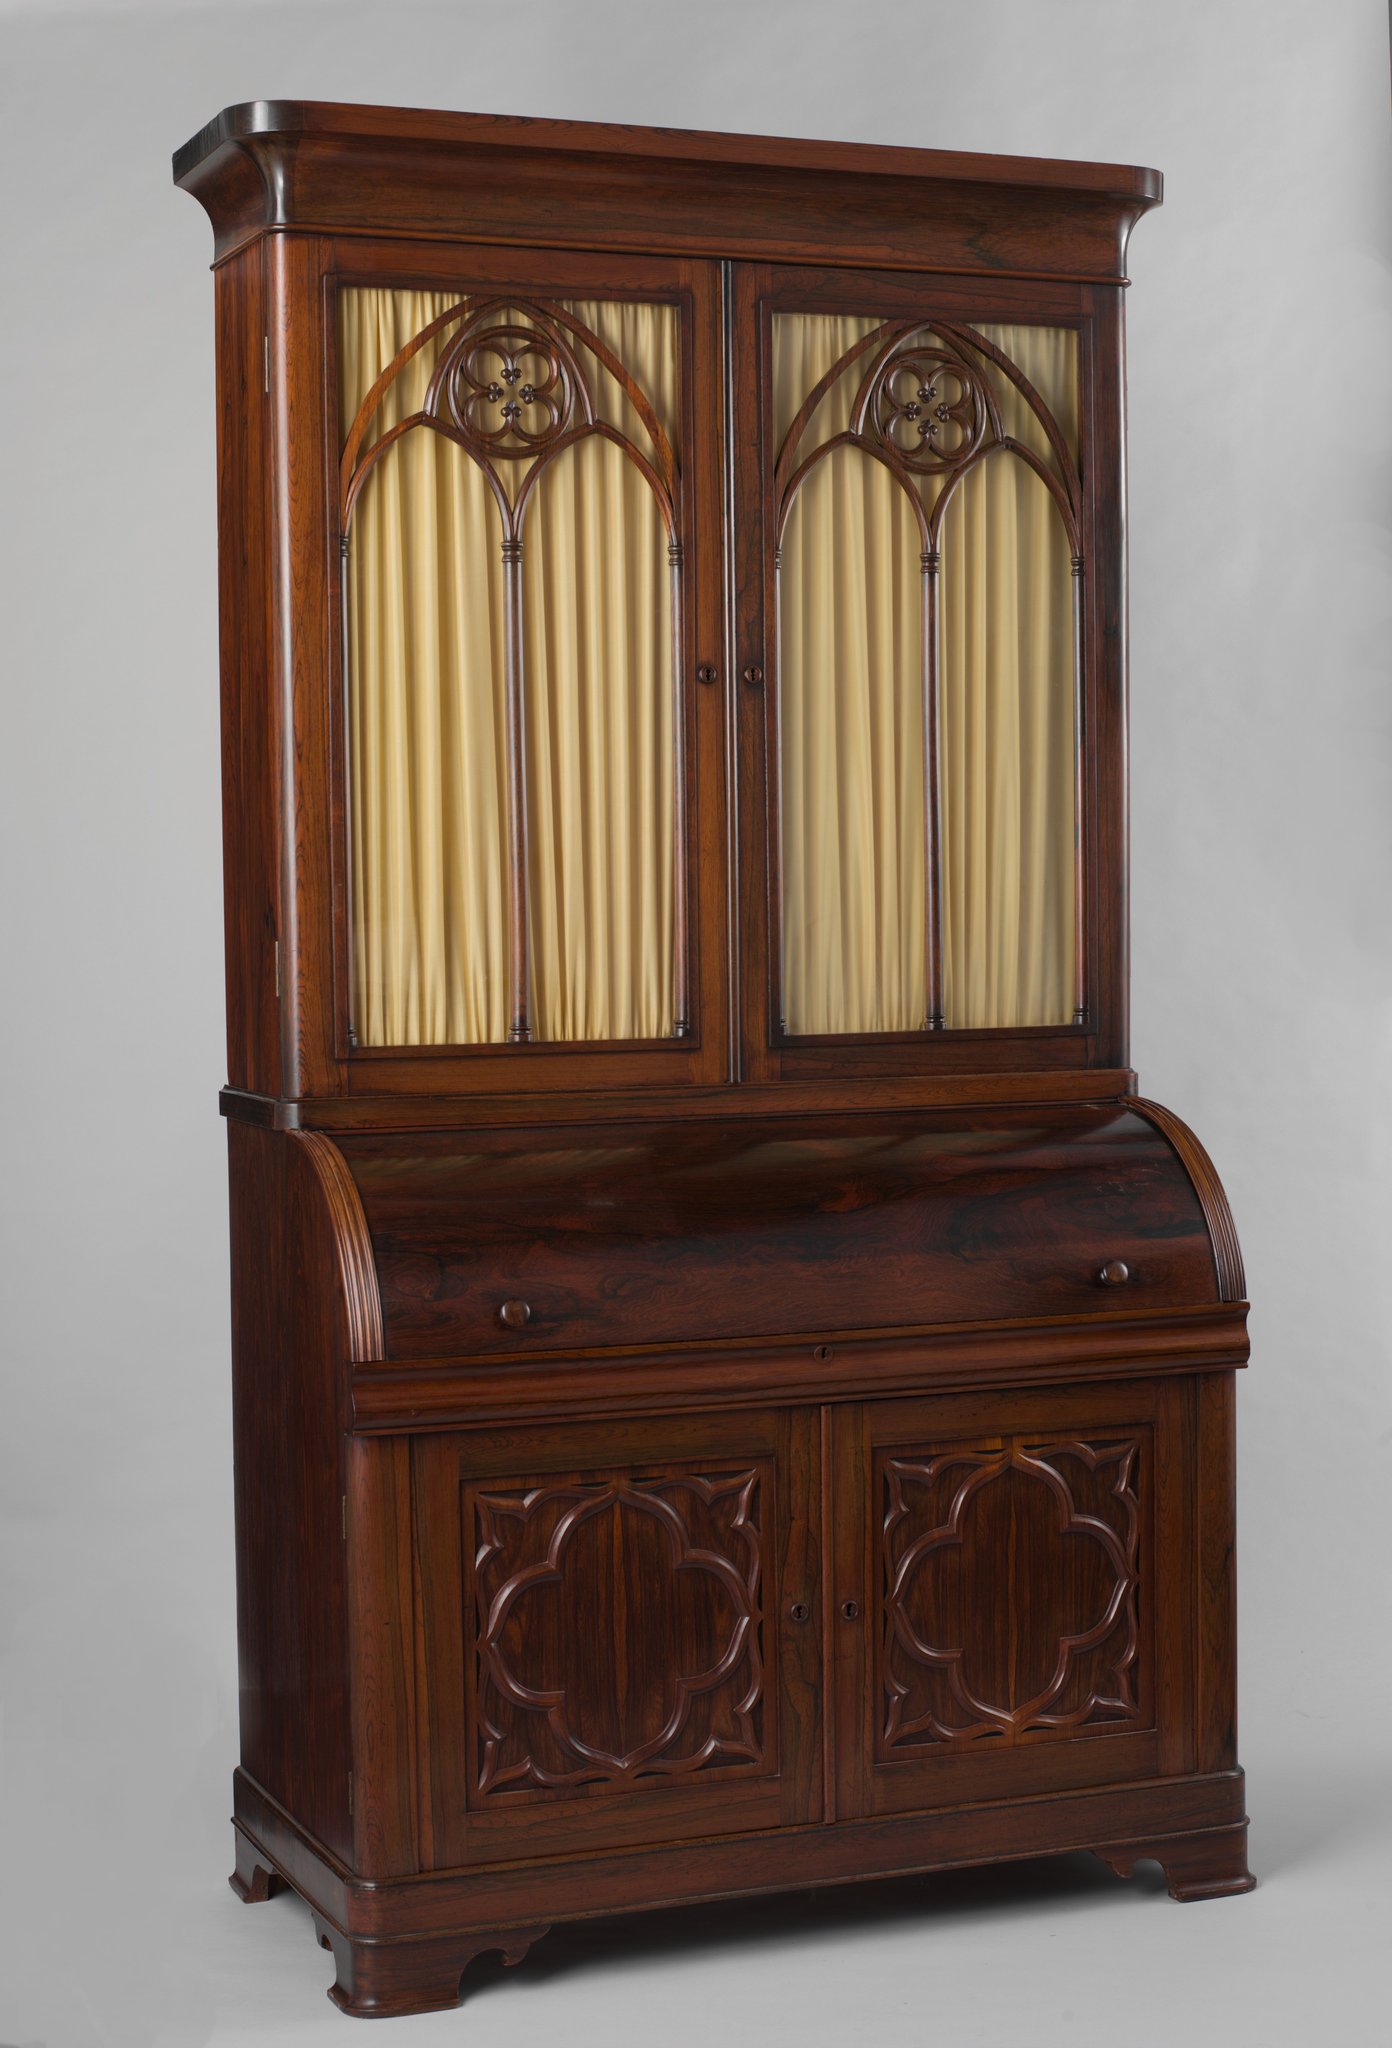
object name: secretary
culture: american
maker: john and joseph w. meeks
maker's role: maker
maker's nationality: american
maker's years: 1833-1859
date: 1836-1850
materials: wood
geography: united states